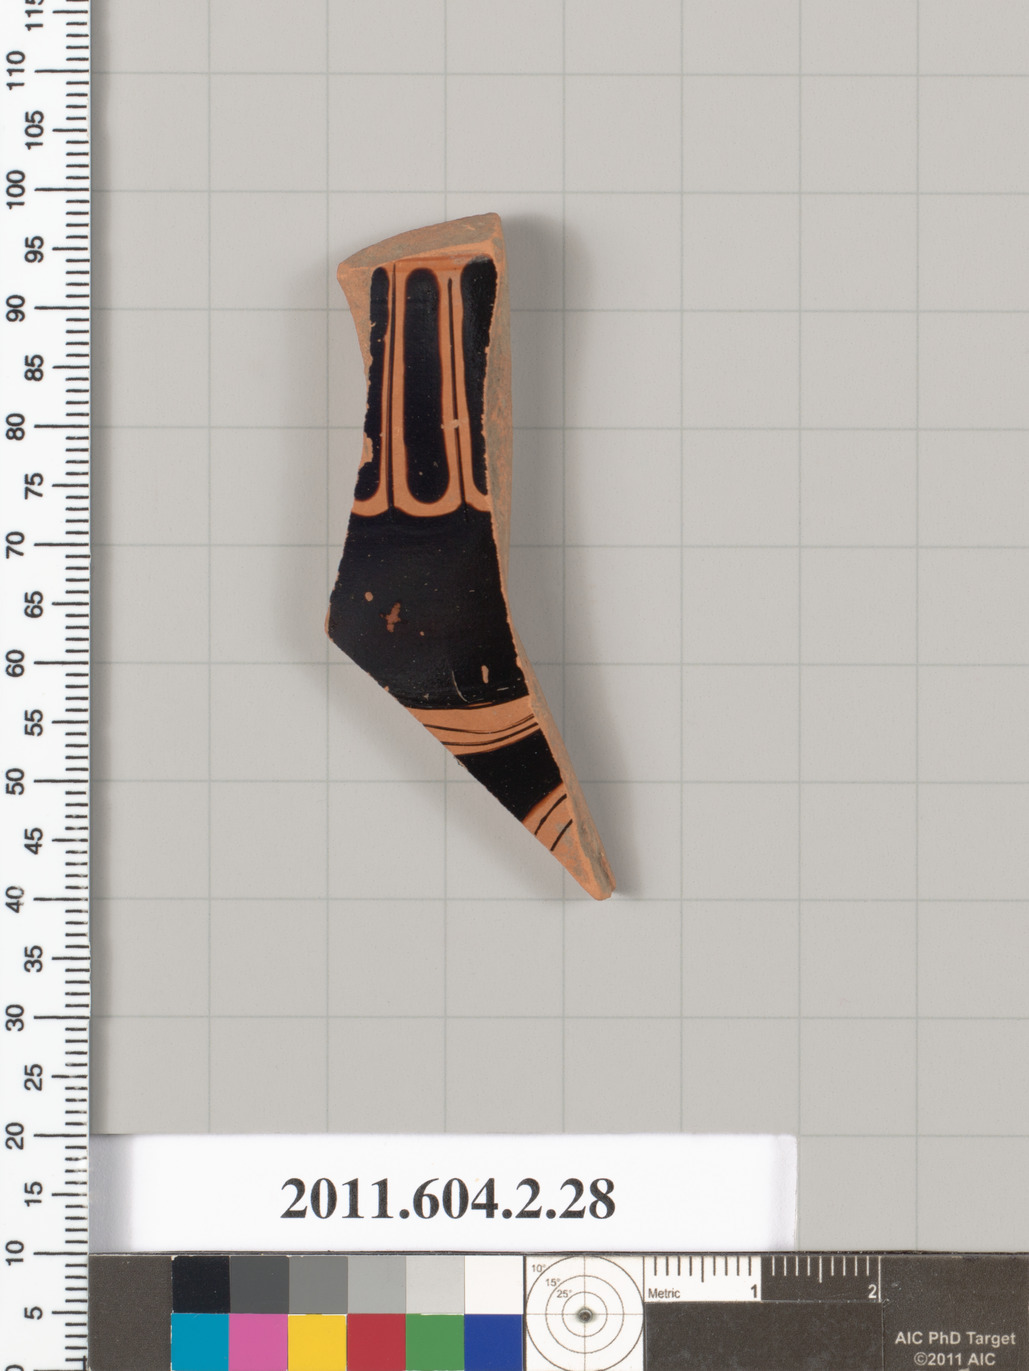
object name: psykter fragment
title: Terracotta fragment of a psykter (vase for cooling wine)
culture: greek, attic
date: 510-500 BCE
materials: terracotta